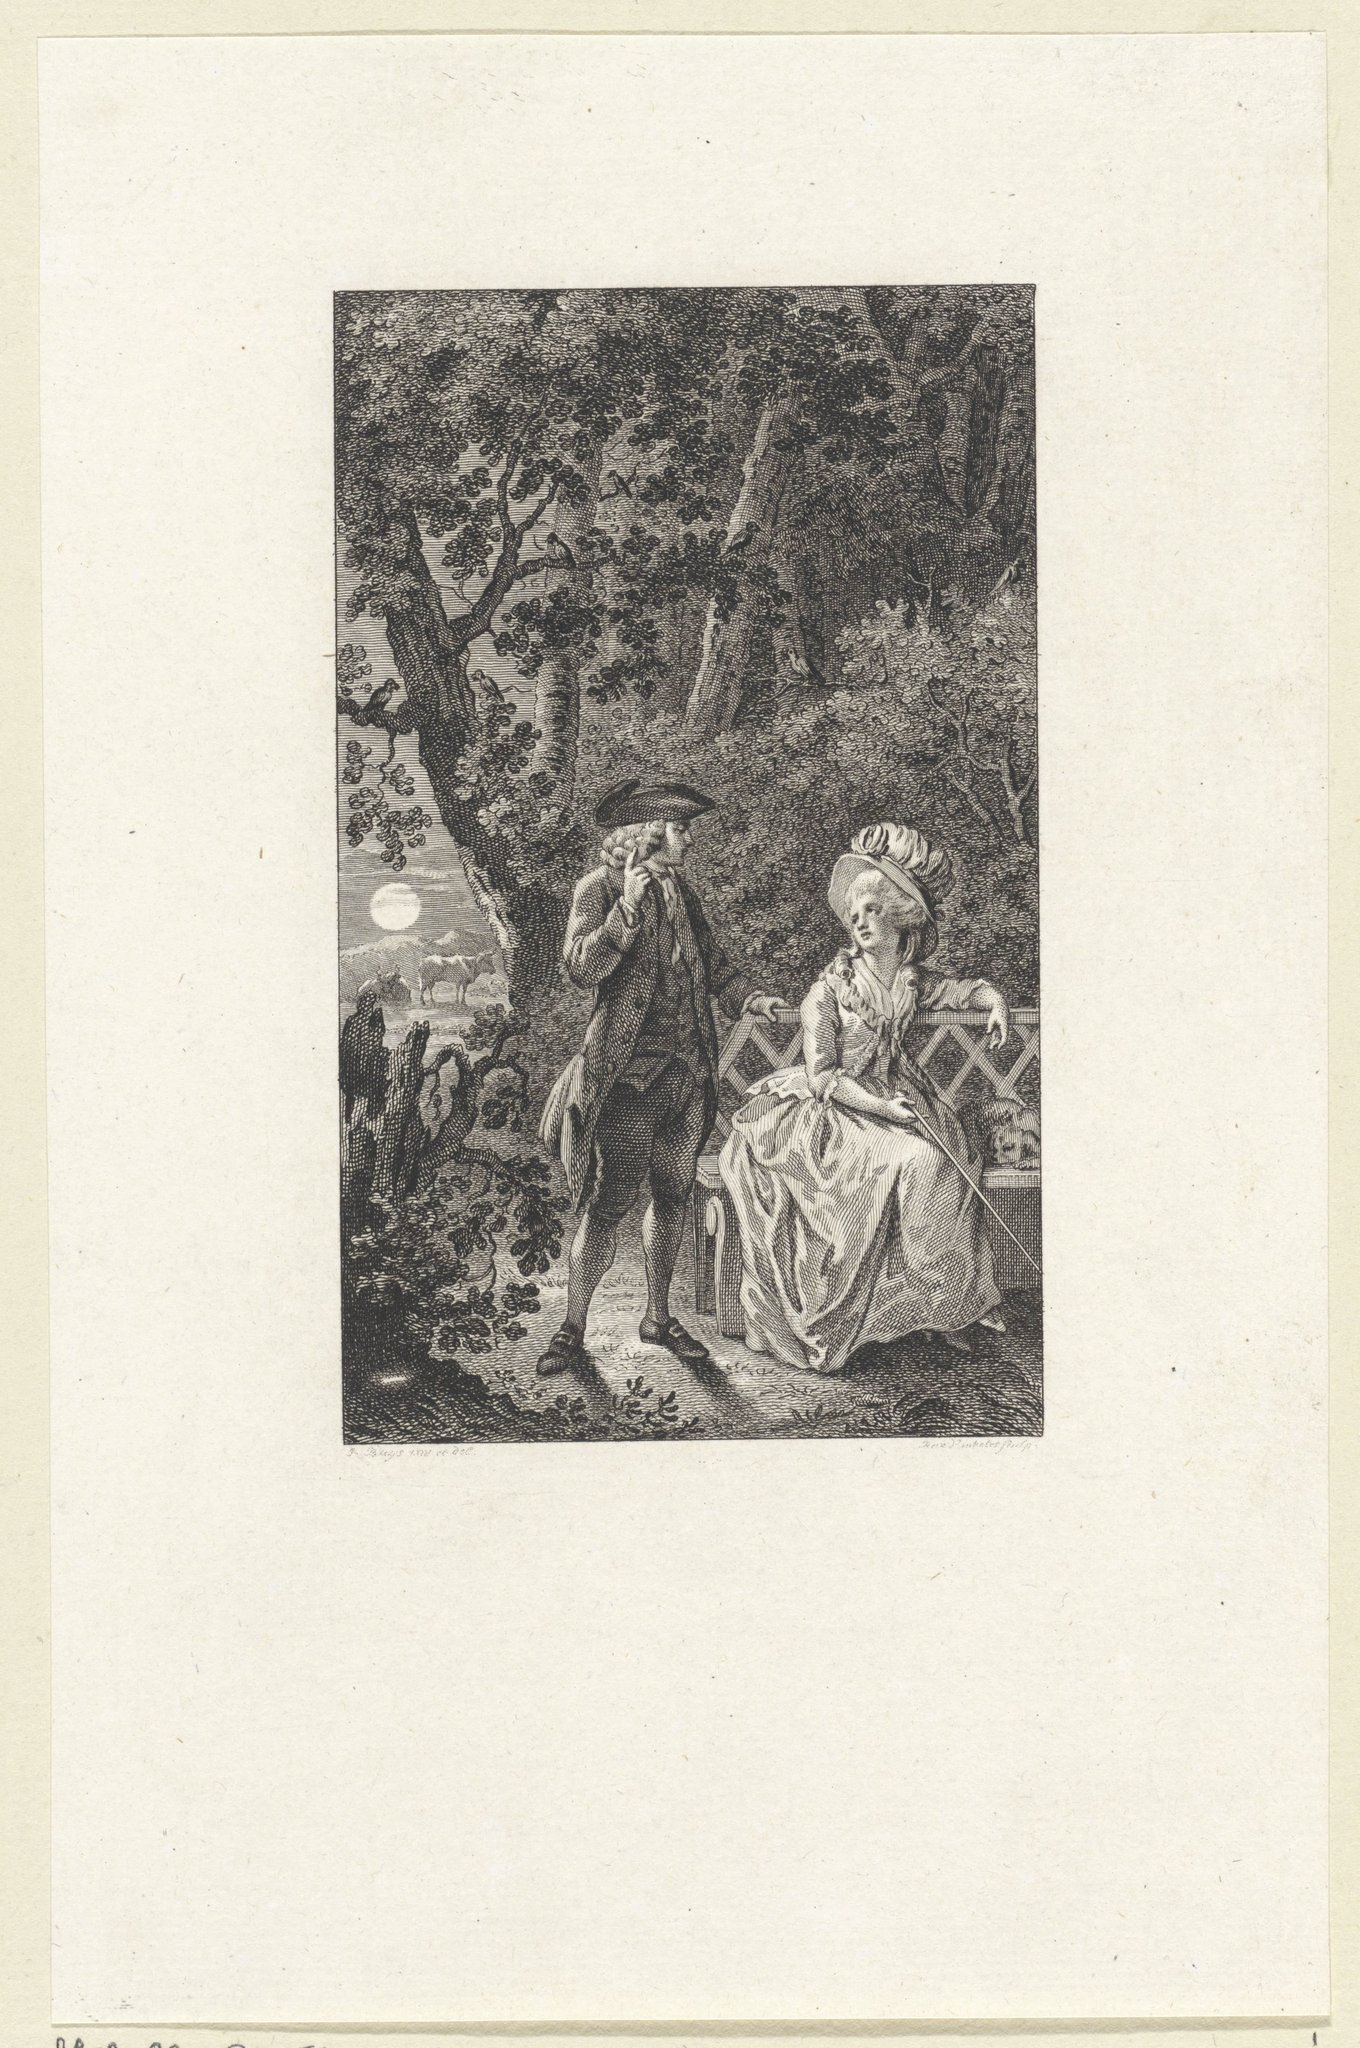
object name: print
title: Nachtgezicht met een paar bij een bank aan de bosrand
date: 1789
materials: paper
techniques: engraving, etching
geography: amsterdam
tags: full moon, cow, forest, wood, couple of lovers, night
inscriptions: collector's mark: Lugt 240